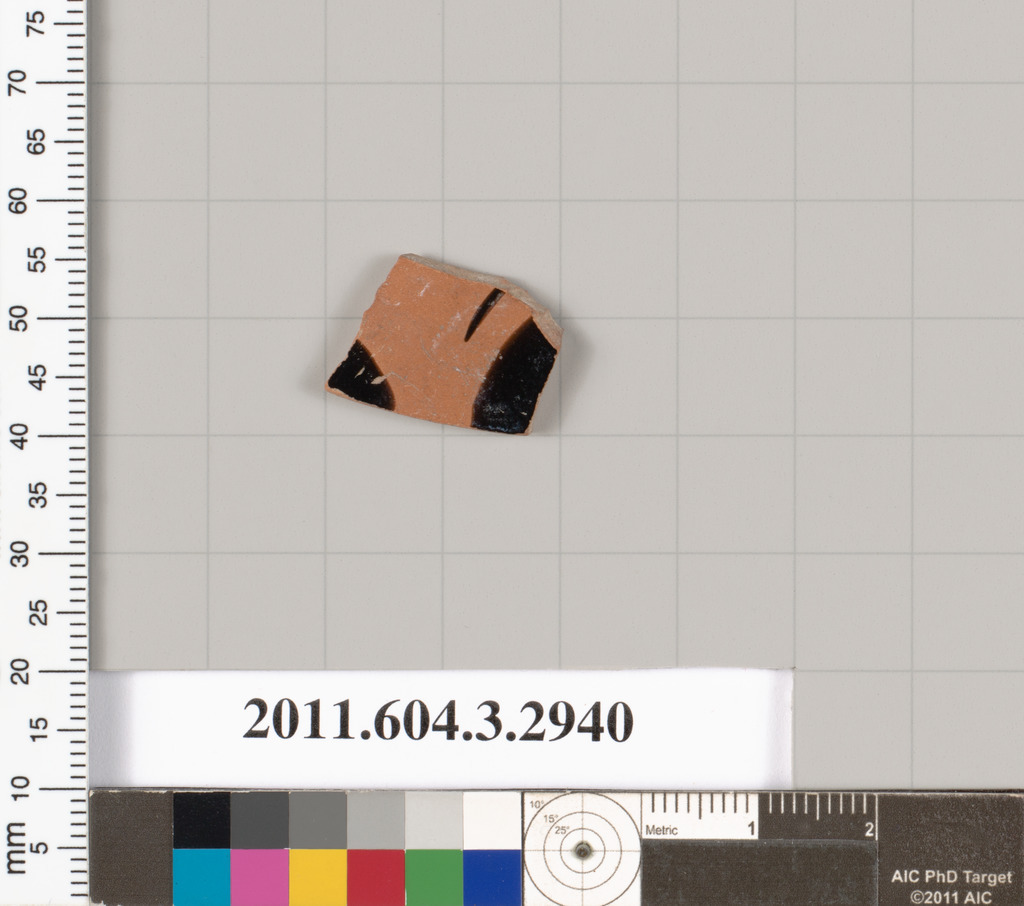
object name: kylix fragment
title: Terracotta fragment of a kylix: eye-cup (drinking cup)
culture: greek, attic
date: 540-510 BCE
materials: terracotta